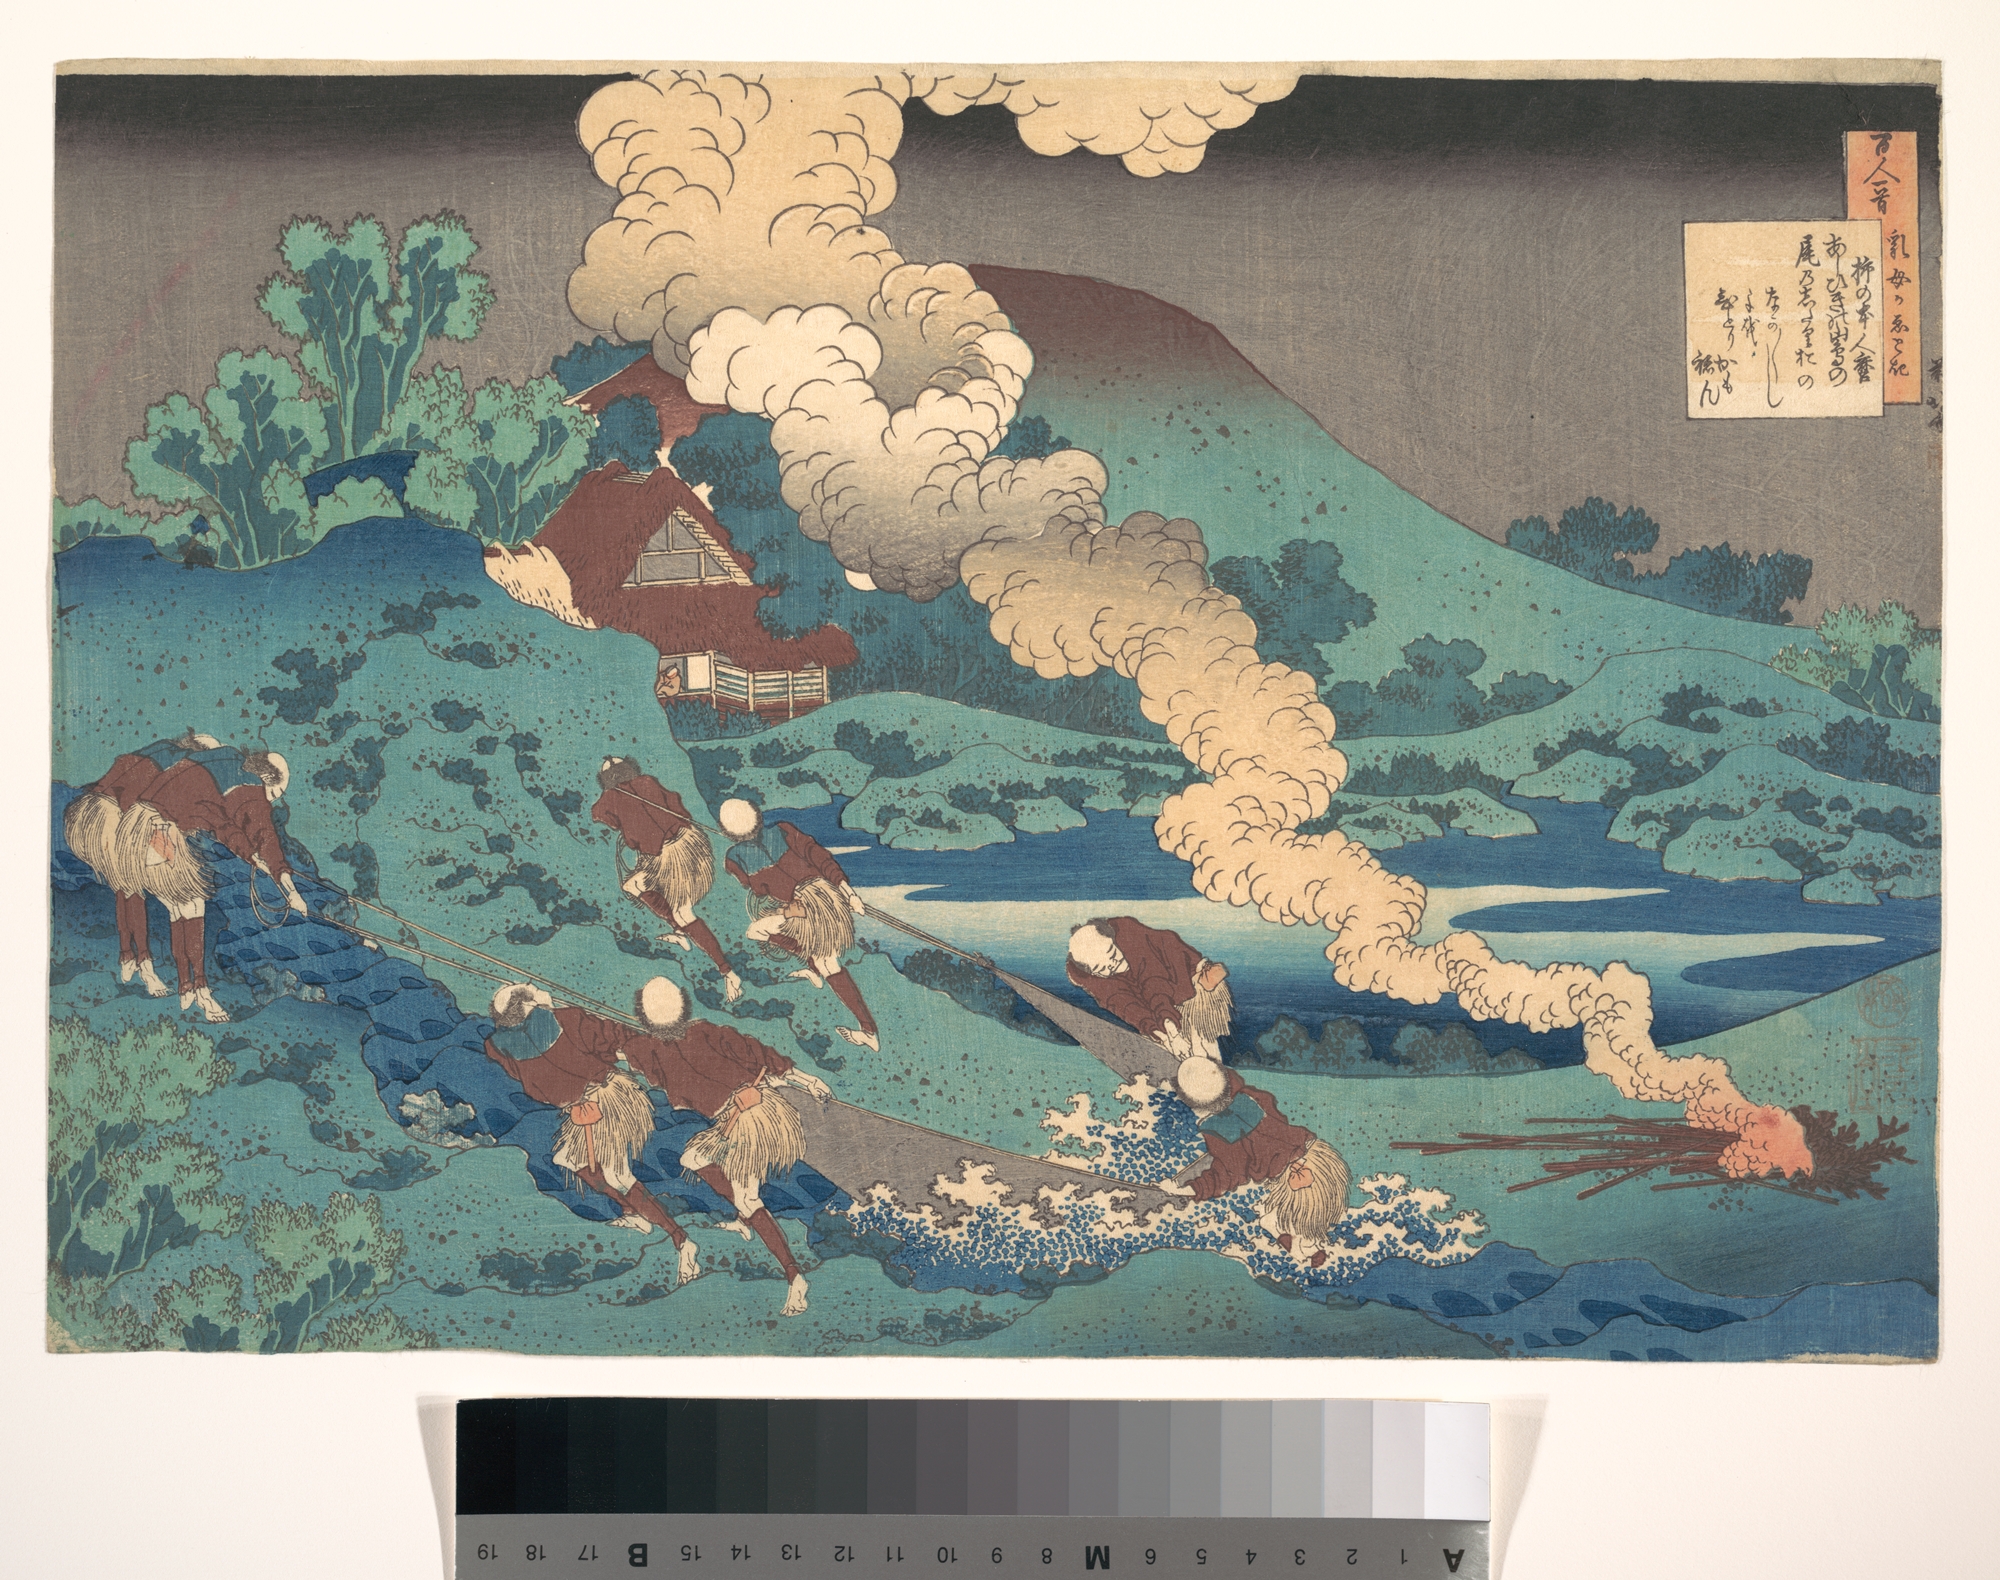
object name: woodblock print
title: Poem by Kakinomoto Hitomaro, from the series One Hundred Poems Explained by the Nurse (Hyakunin isshu uba ga etoki)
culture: japanese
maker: katsushika hokusai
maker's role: artist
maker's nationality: japanese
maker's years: 1760-1849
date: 1760-1849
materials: ink, paper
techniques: woodblock print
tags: human figures,mountains,landscapes